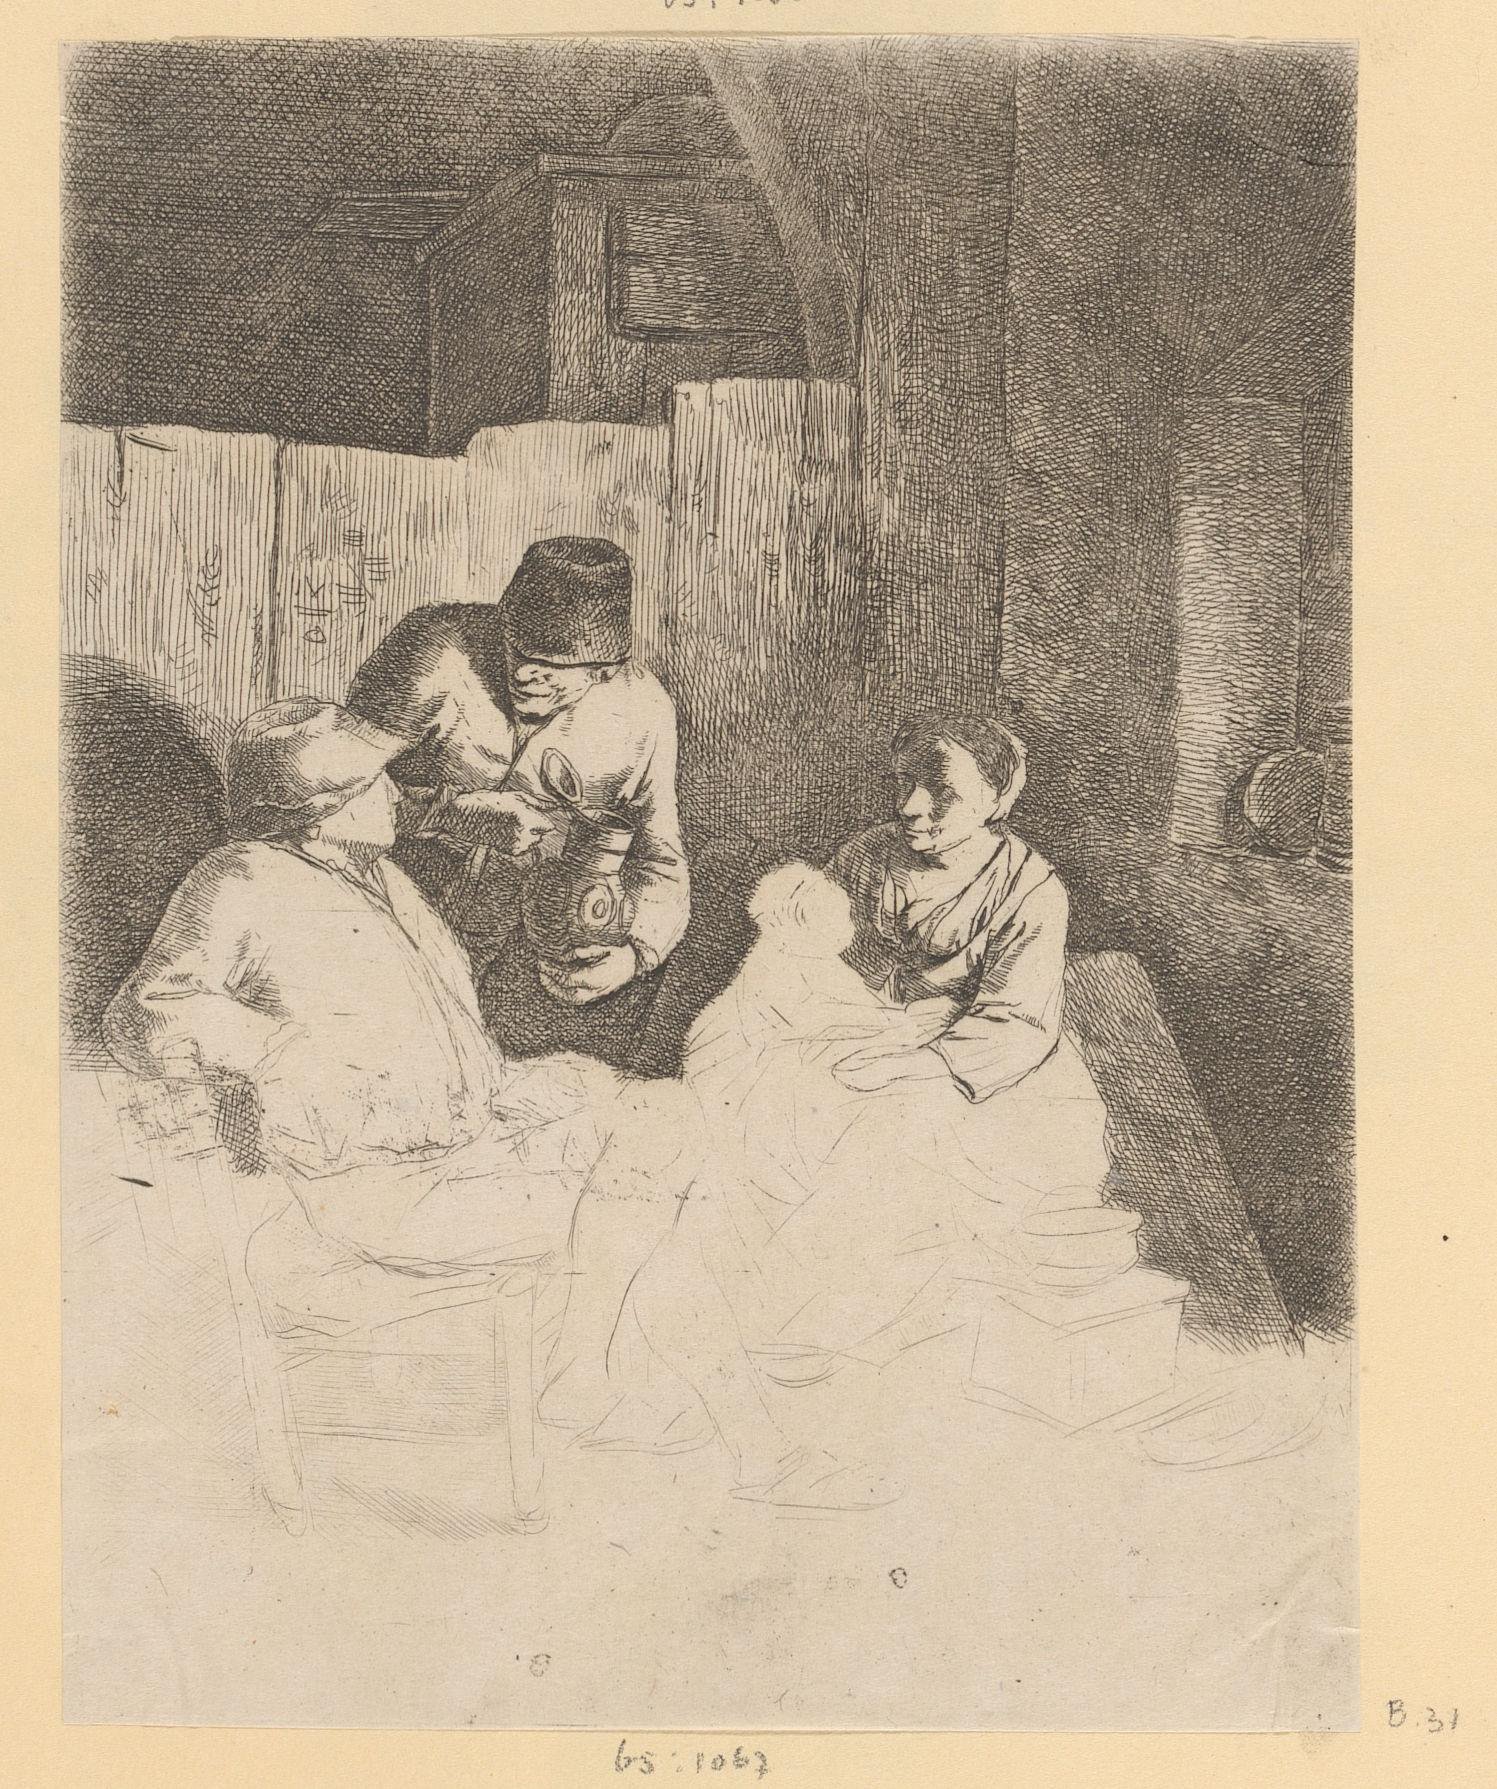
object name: print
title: Herberg met moeder en kind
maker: cornelis pietersz. bega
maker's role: draughtsman, painter, print maker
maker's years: 1631-1664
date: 1641-1664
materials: paper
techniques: etching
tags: mother and baby or young child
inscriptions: date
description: Prent maakt mogelijk deel uit van een serie van 200 prenten. Deze serie is onder de titel 'A Collection of two hundred original etchings' voor het eerst uitgegeven door J.M. Greery in 1816.